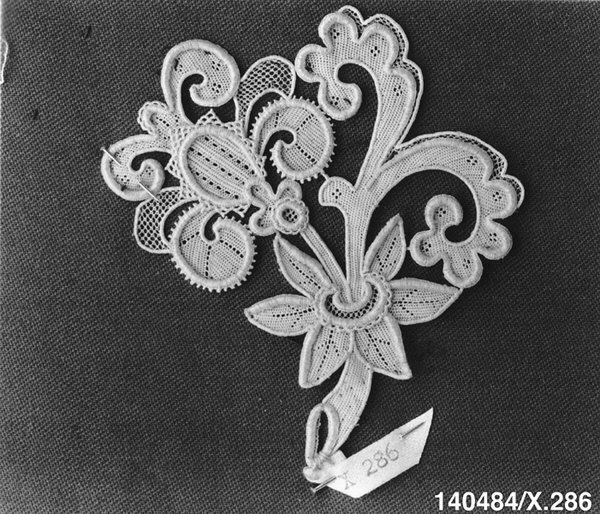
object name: ornament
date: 1801-1900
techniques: lace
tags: flowers